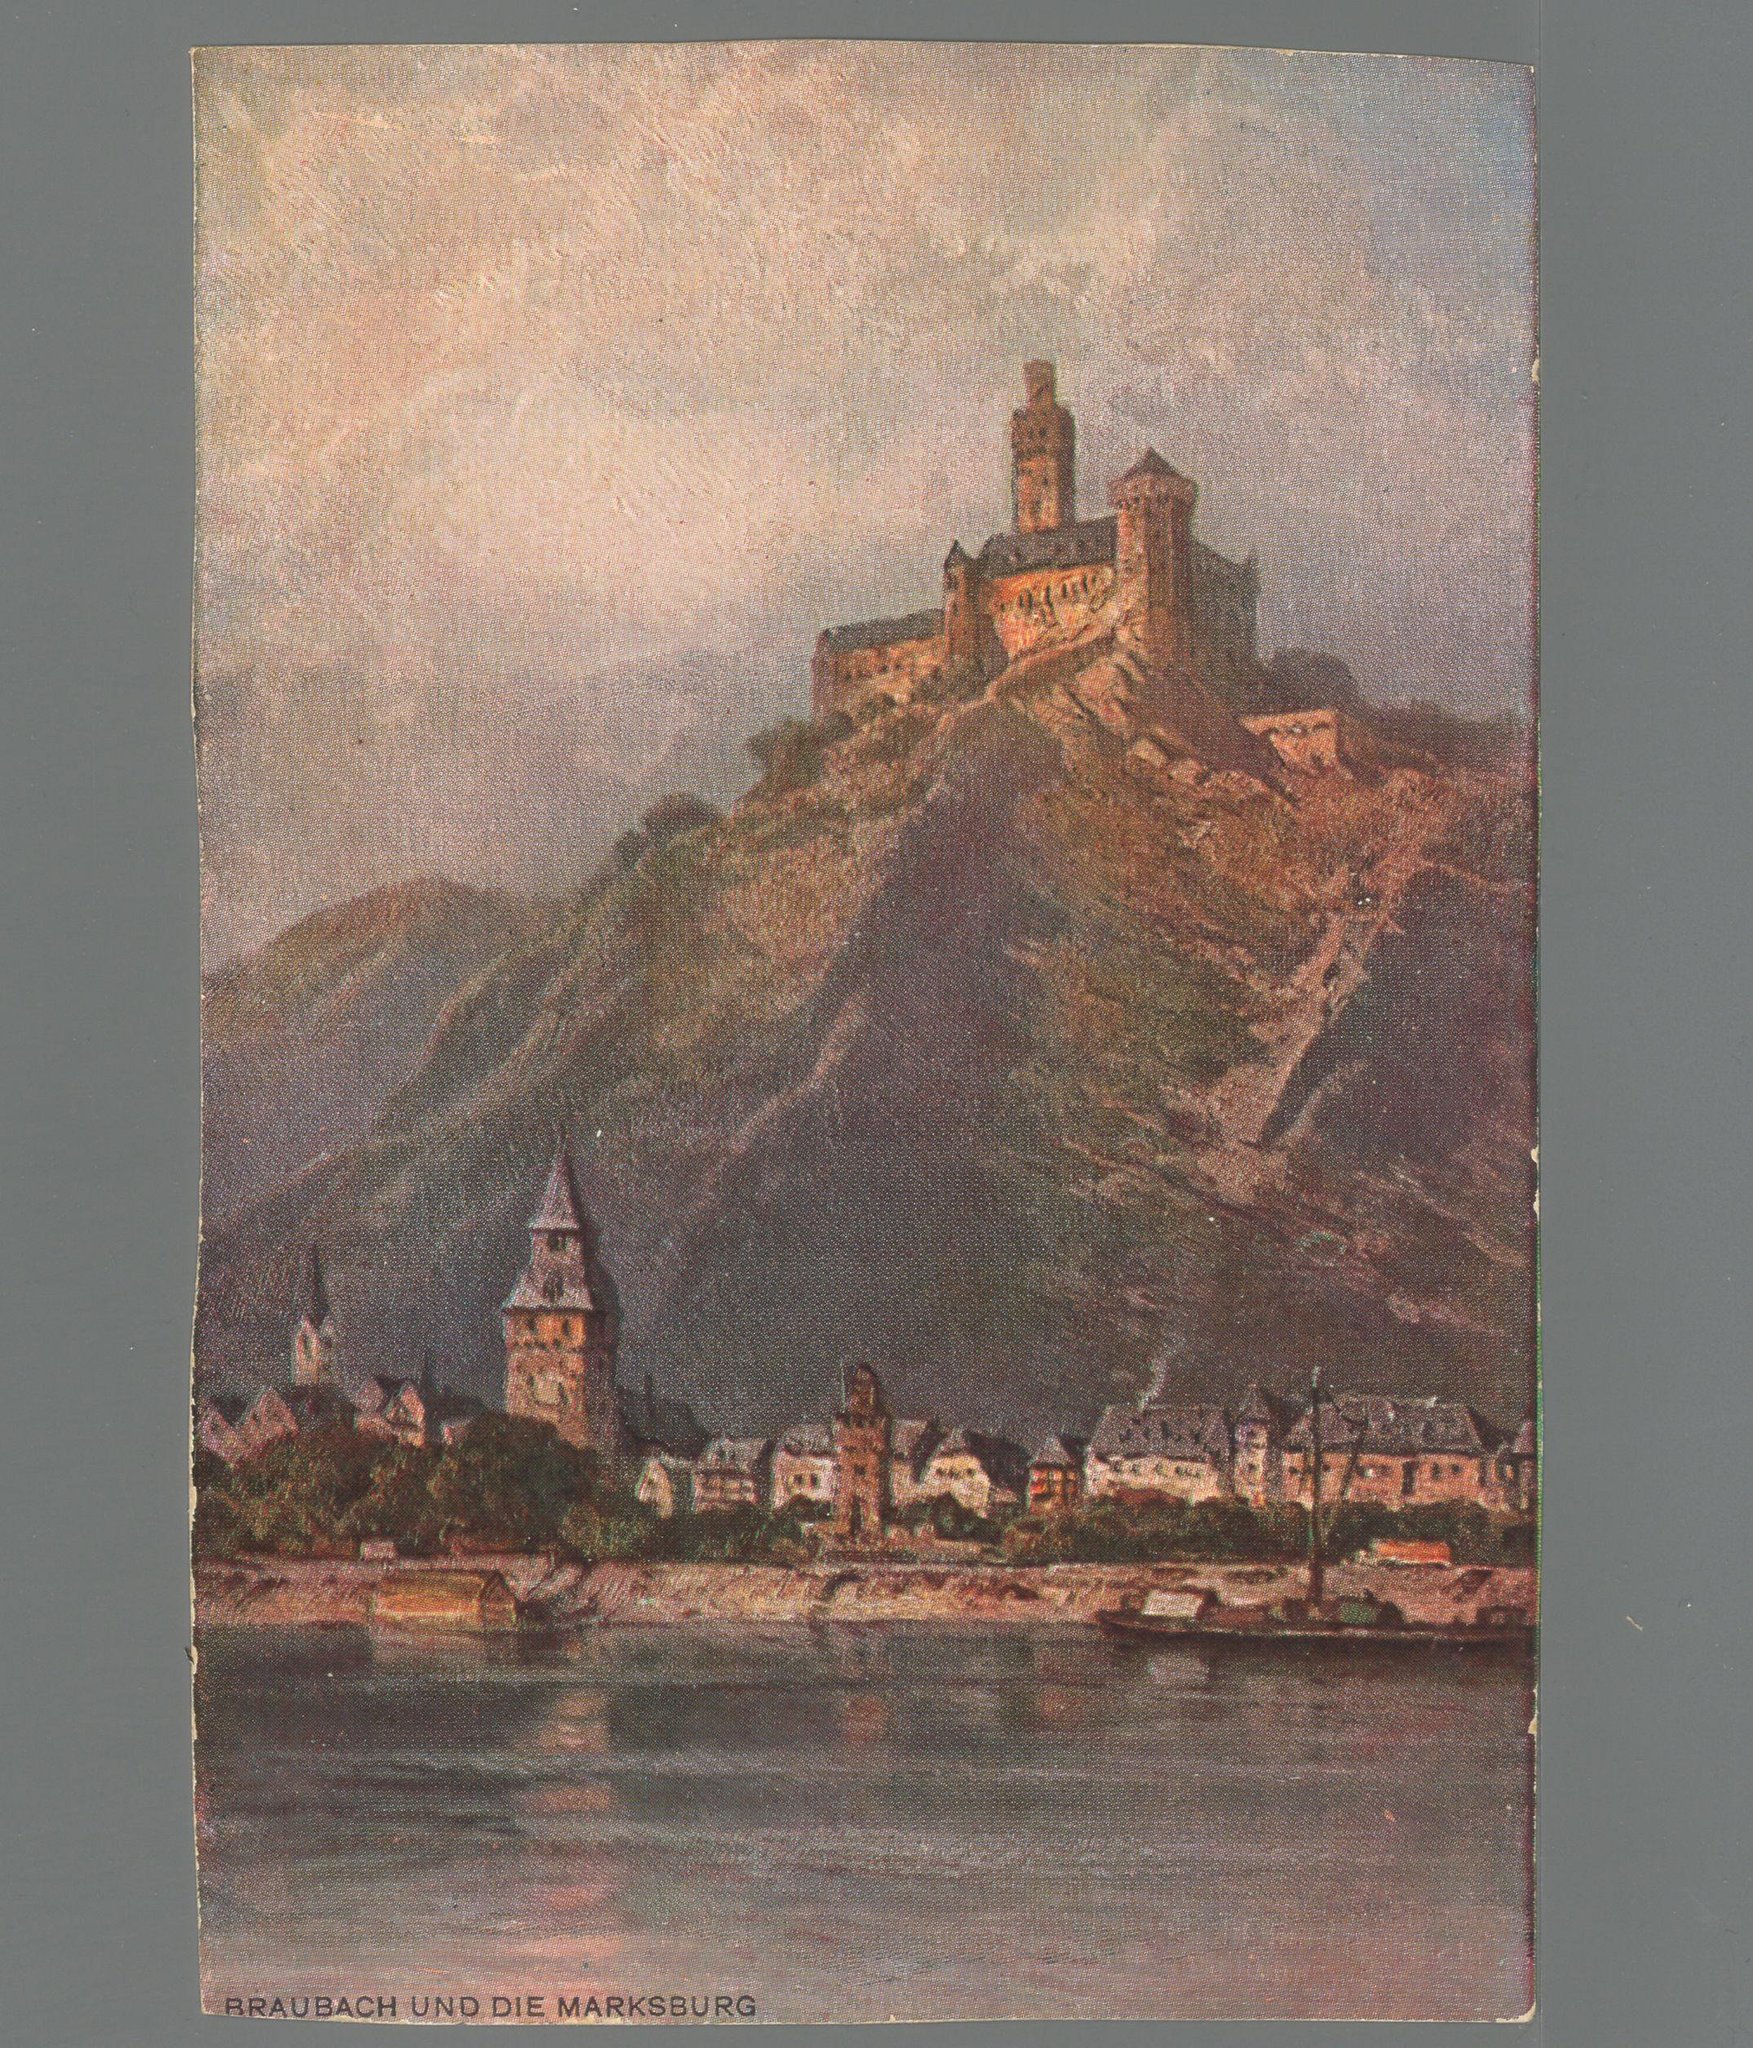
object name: photomechanical print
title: Braubach und die Marksburg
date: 1905-1930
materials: cardboard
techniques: color autotype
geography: cologne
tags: castle, canals, waters (in city)